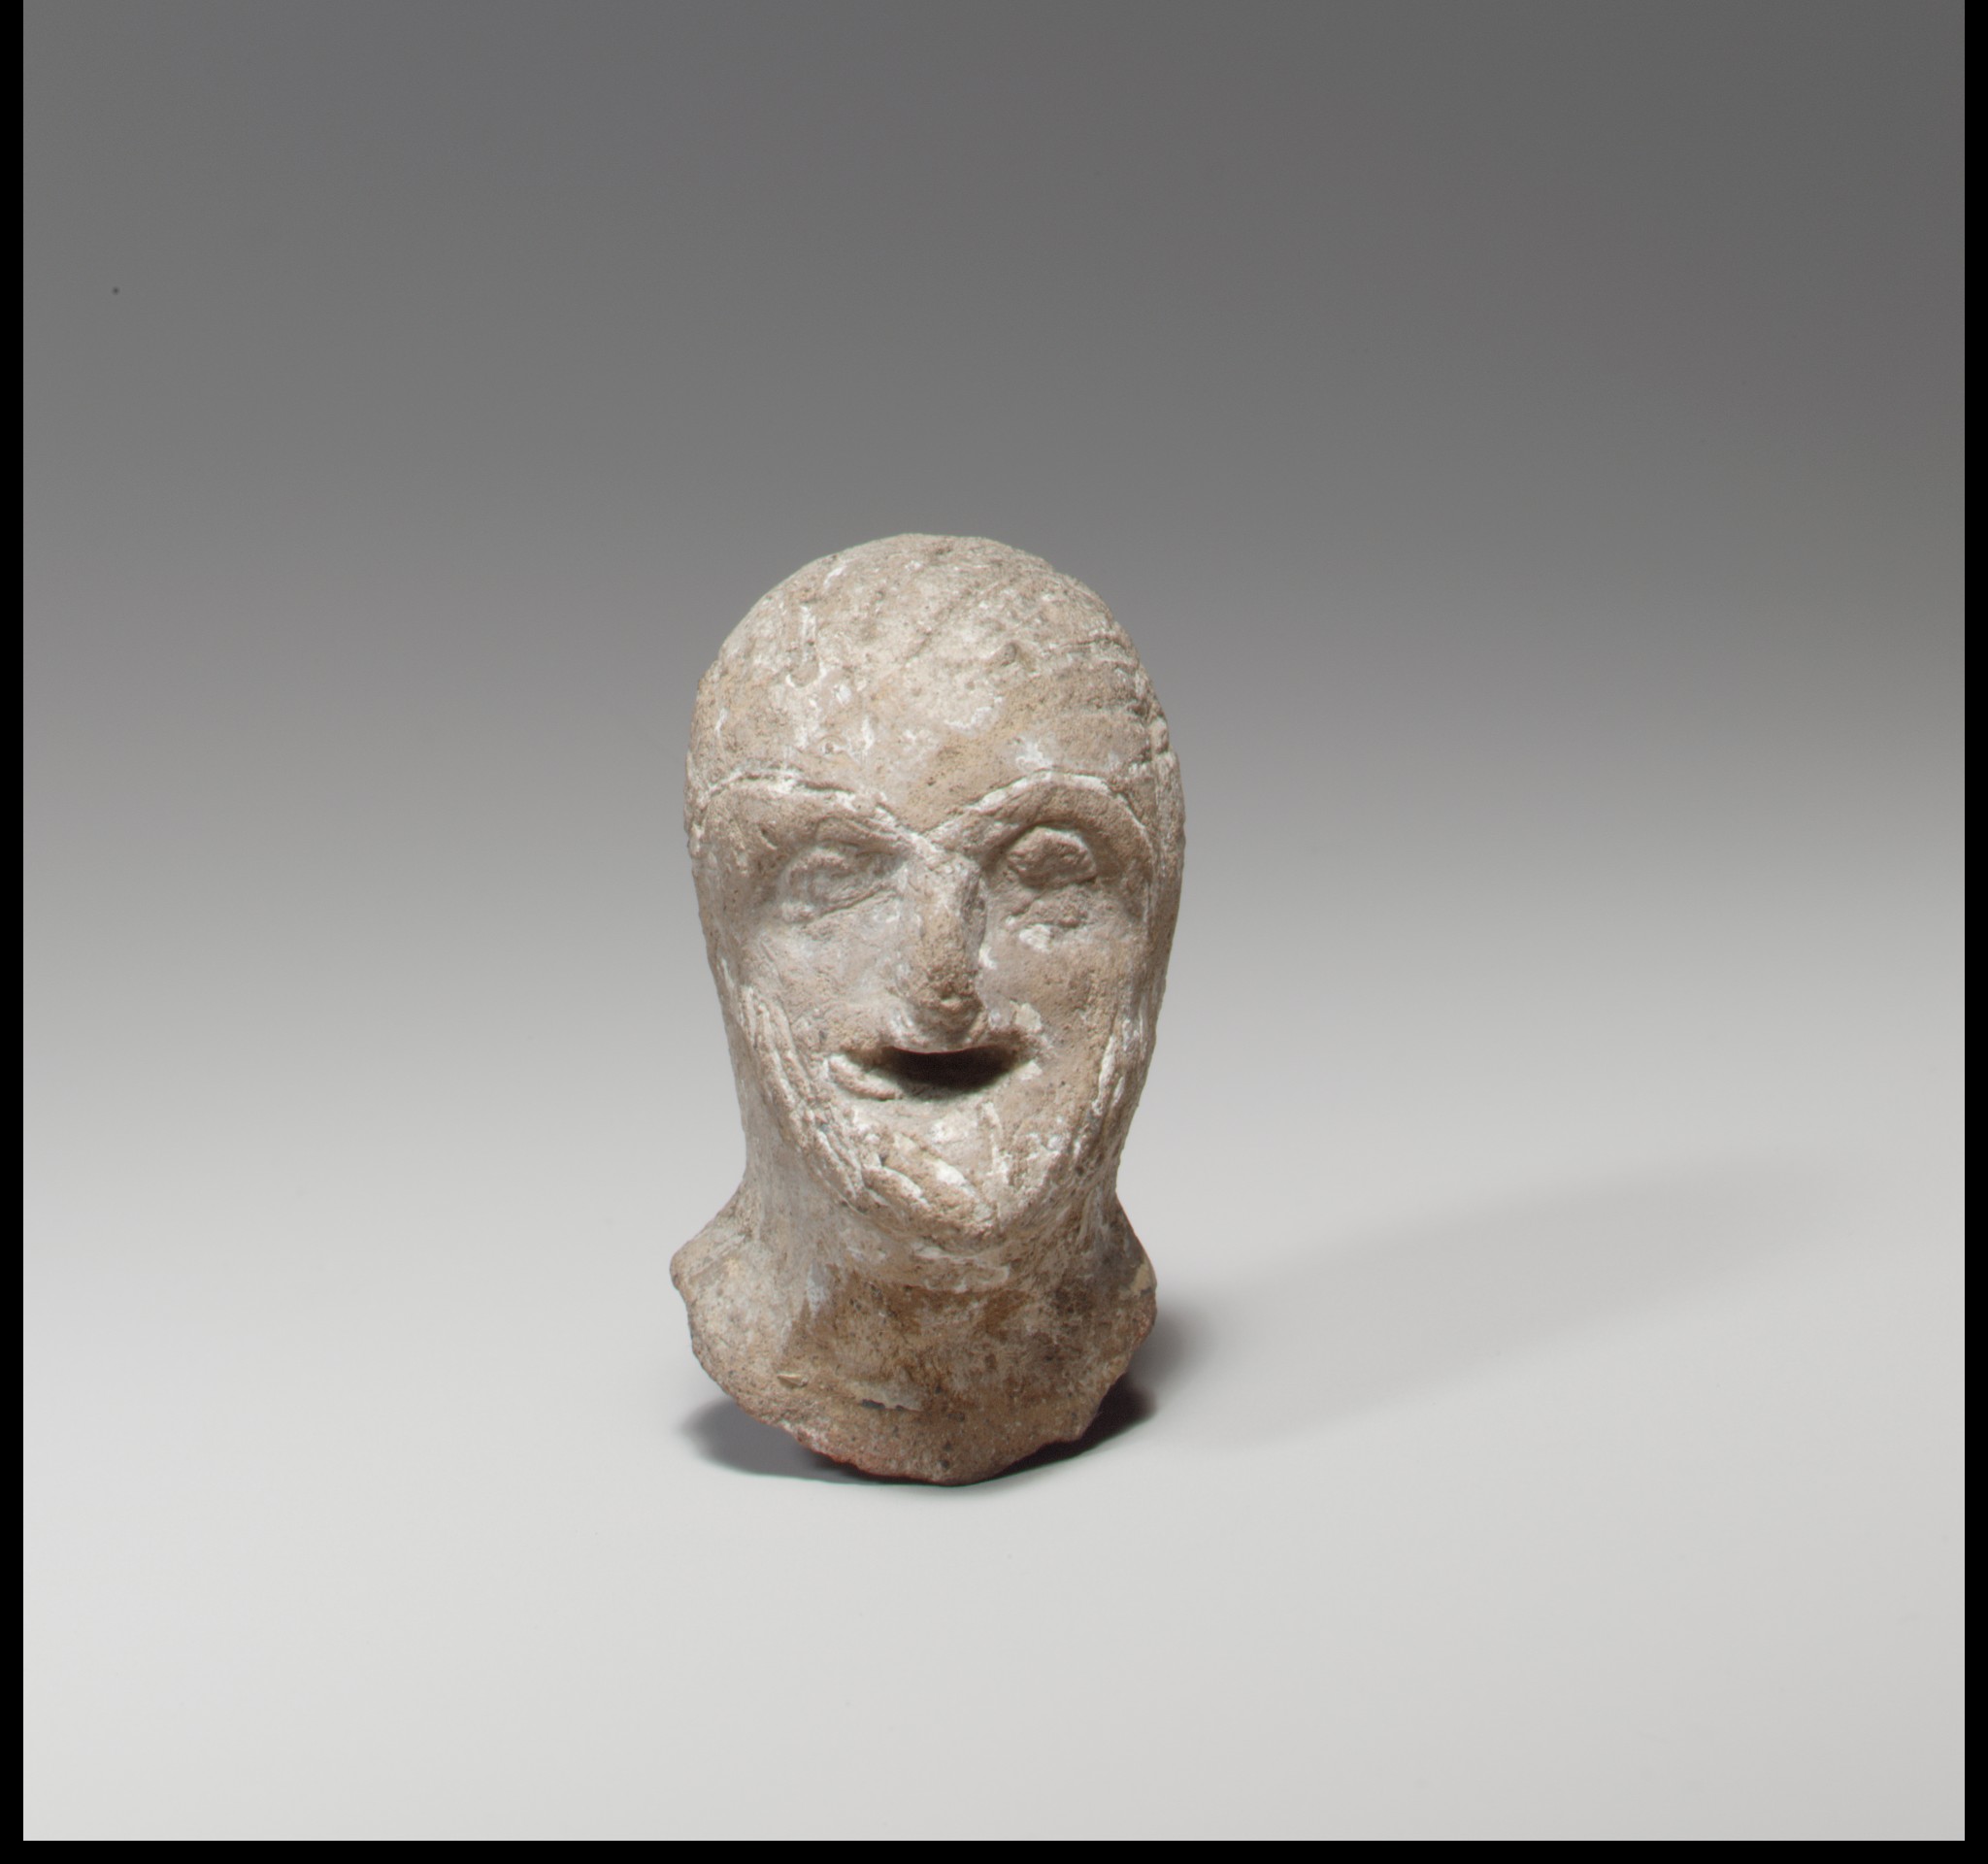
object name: head of a man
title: Head of a comic figurine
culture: cypriot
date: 500-301 BCE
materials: terracotta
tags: heads